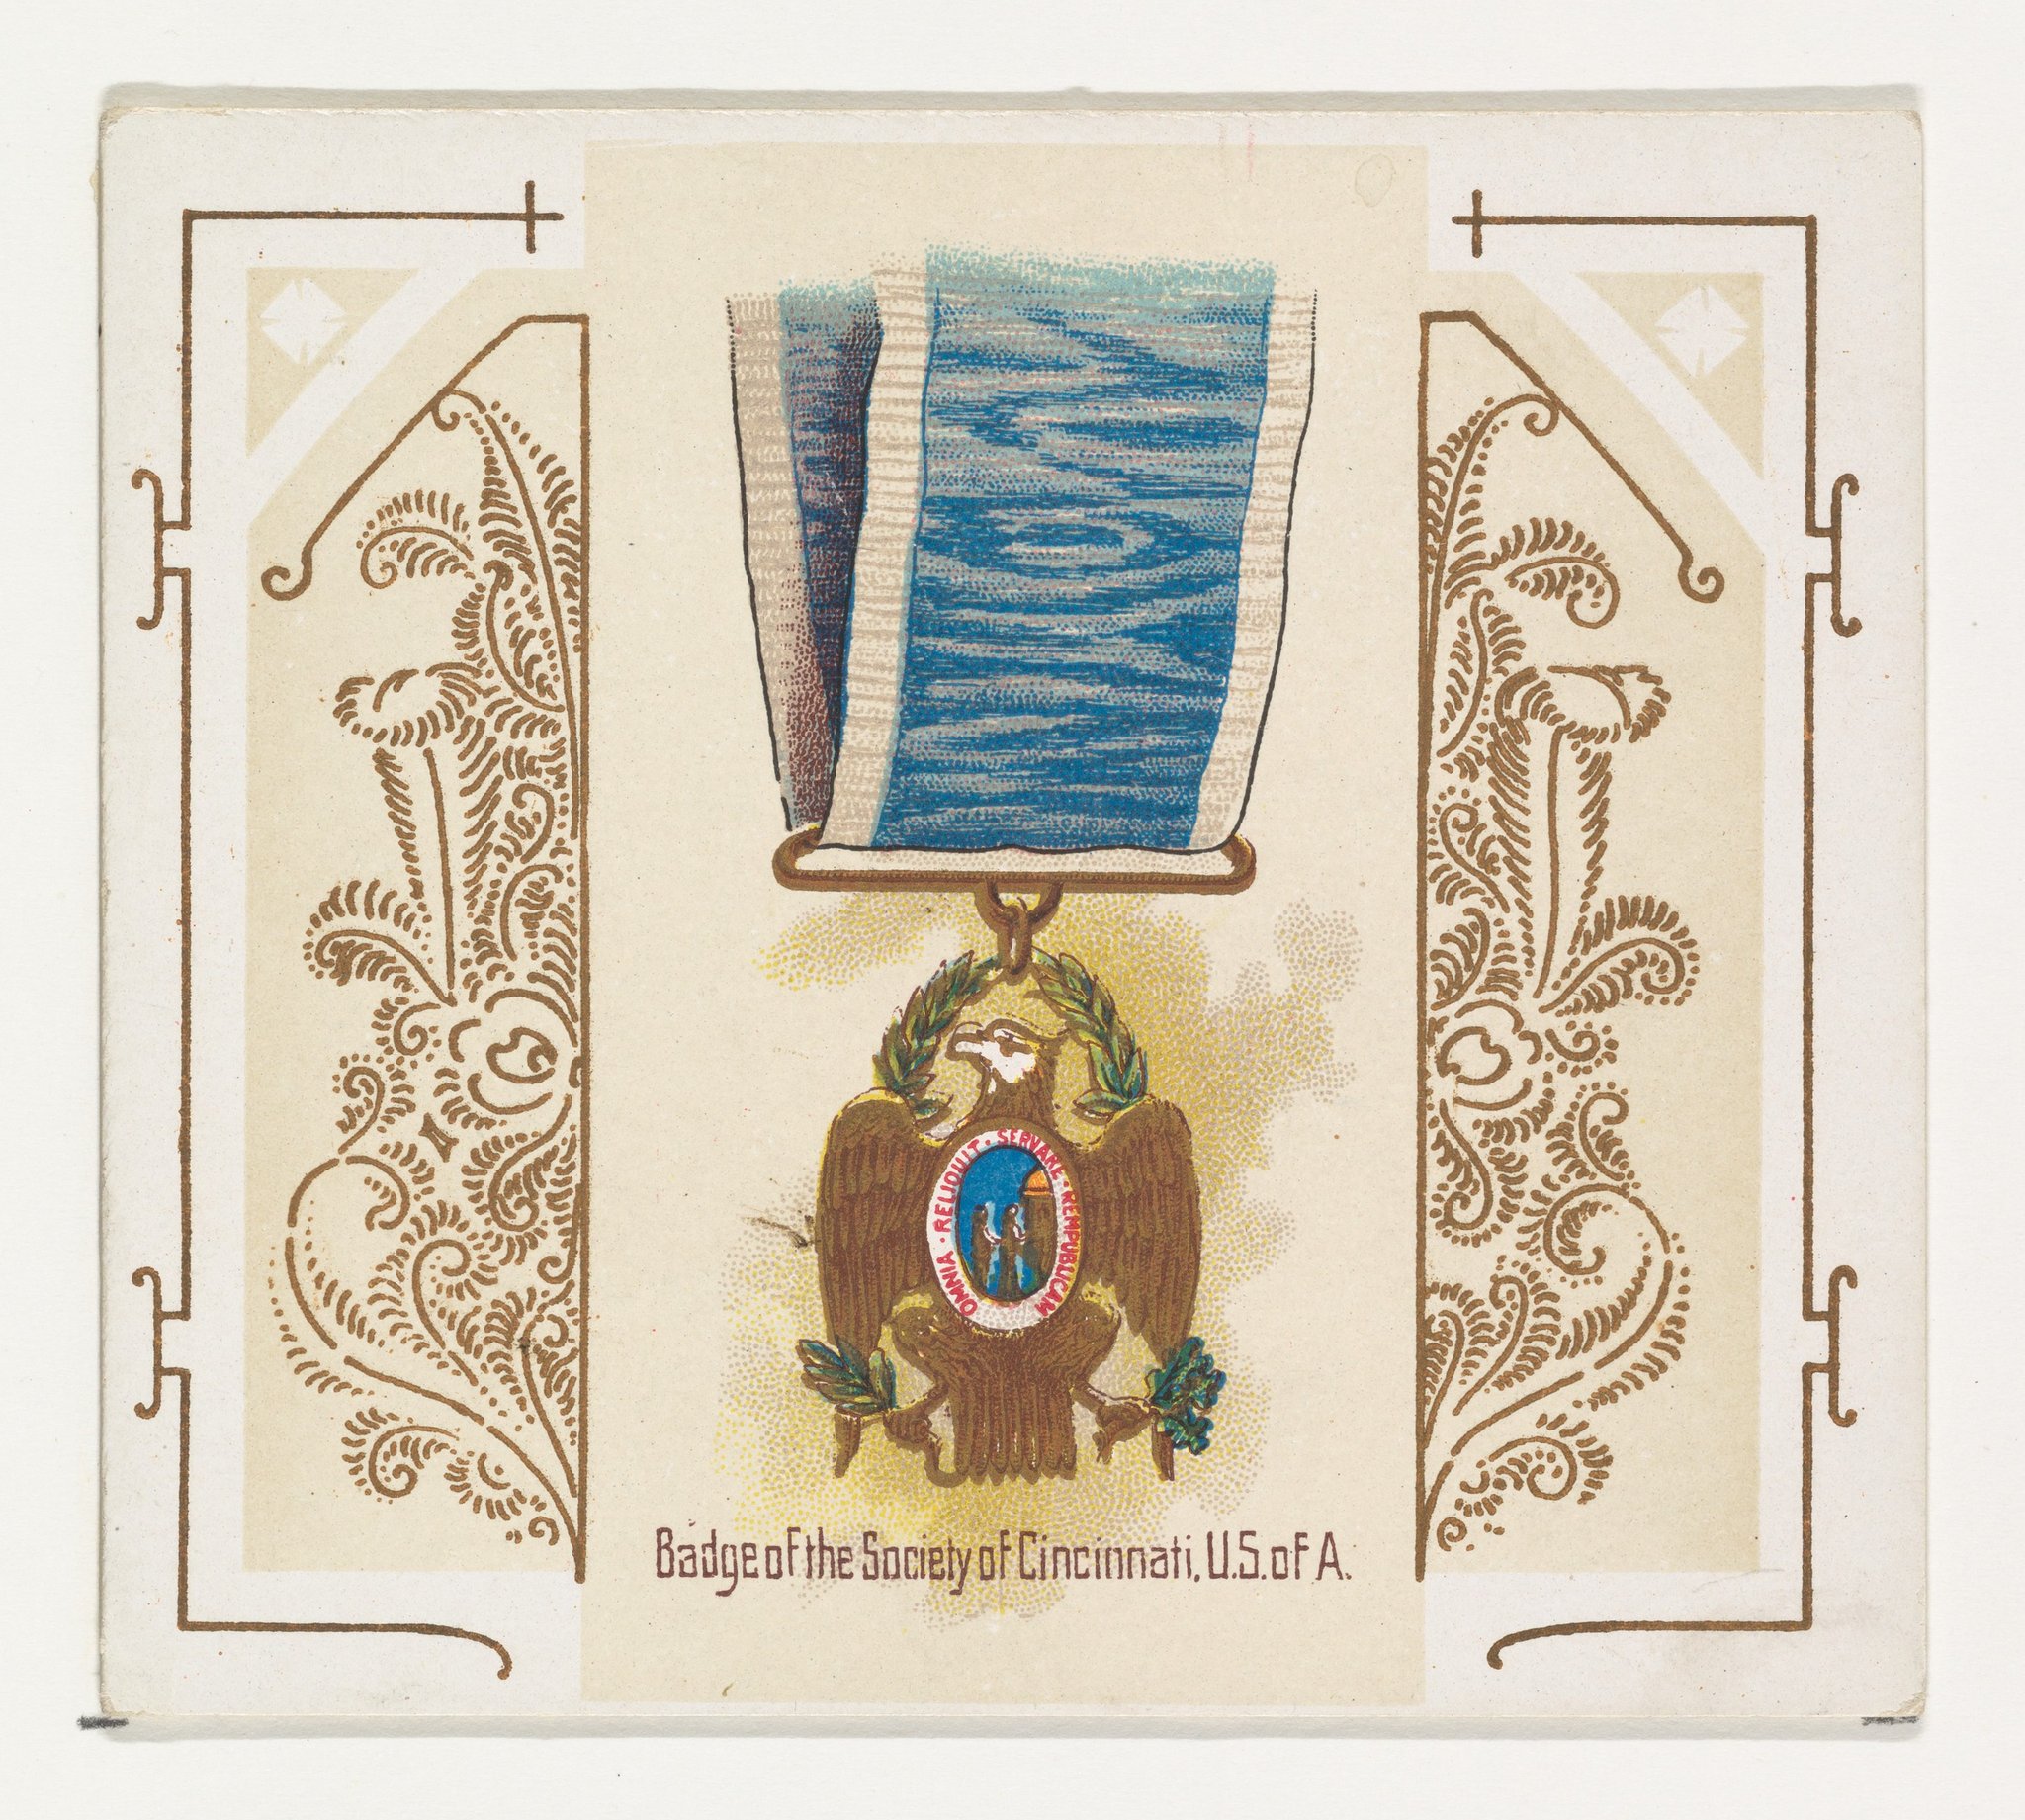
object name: print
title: Badge of the Society of Cincinnati, United States of America, from the World's Decorations series (N44) for Allen & Ginter Cigarettes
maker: allen & ginter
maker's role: publisher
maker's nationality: american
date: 1890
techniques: color lithograph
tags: medals